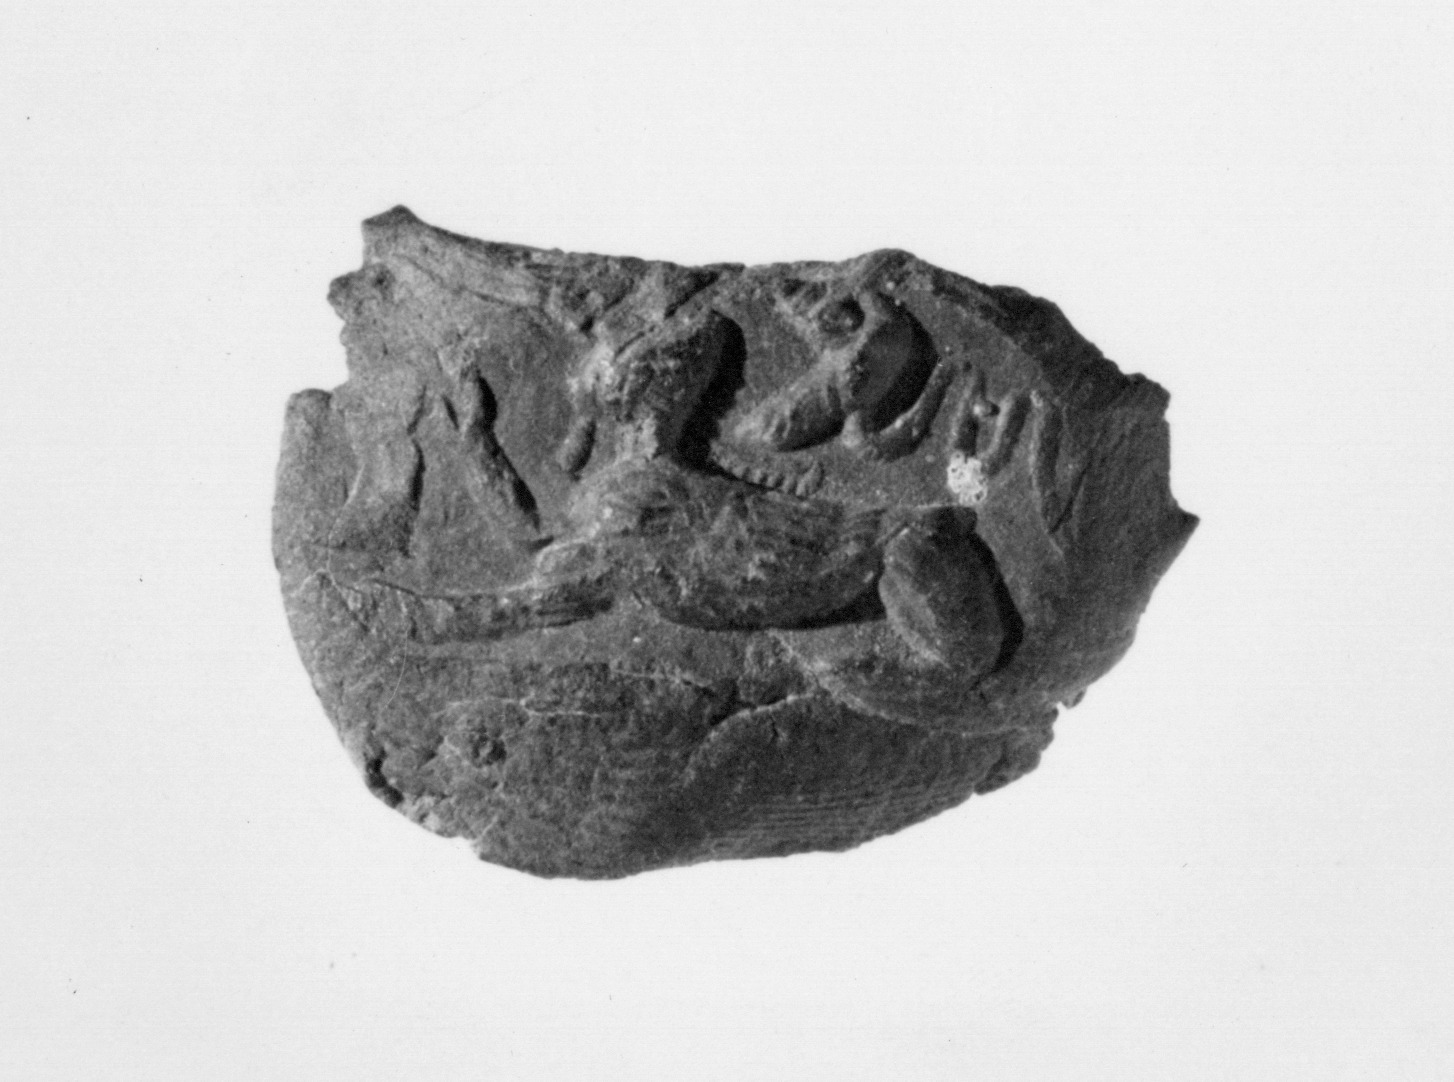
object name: sealing, recumbant sphinx, hand, re, maat winged cobra, uraeus, wedjat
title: Document Sealing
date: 1390-1352 BCE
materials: mud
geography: egypt